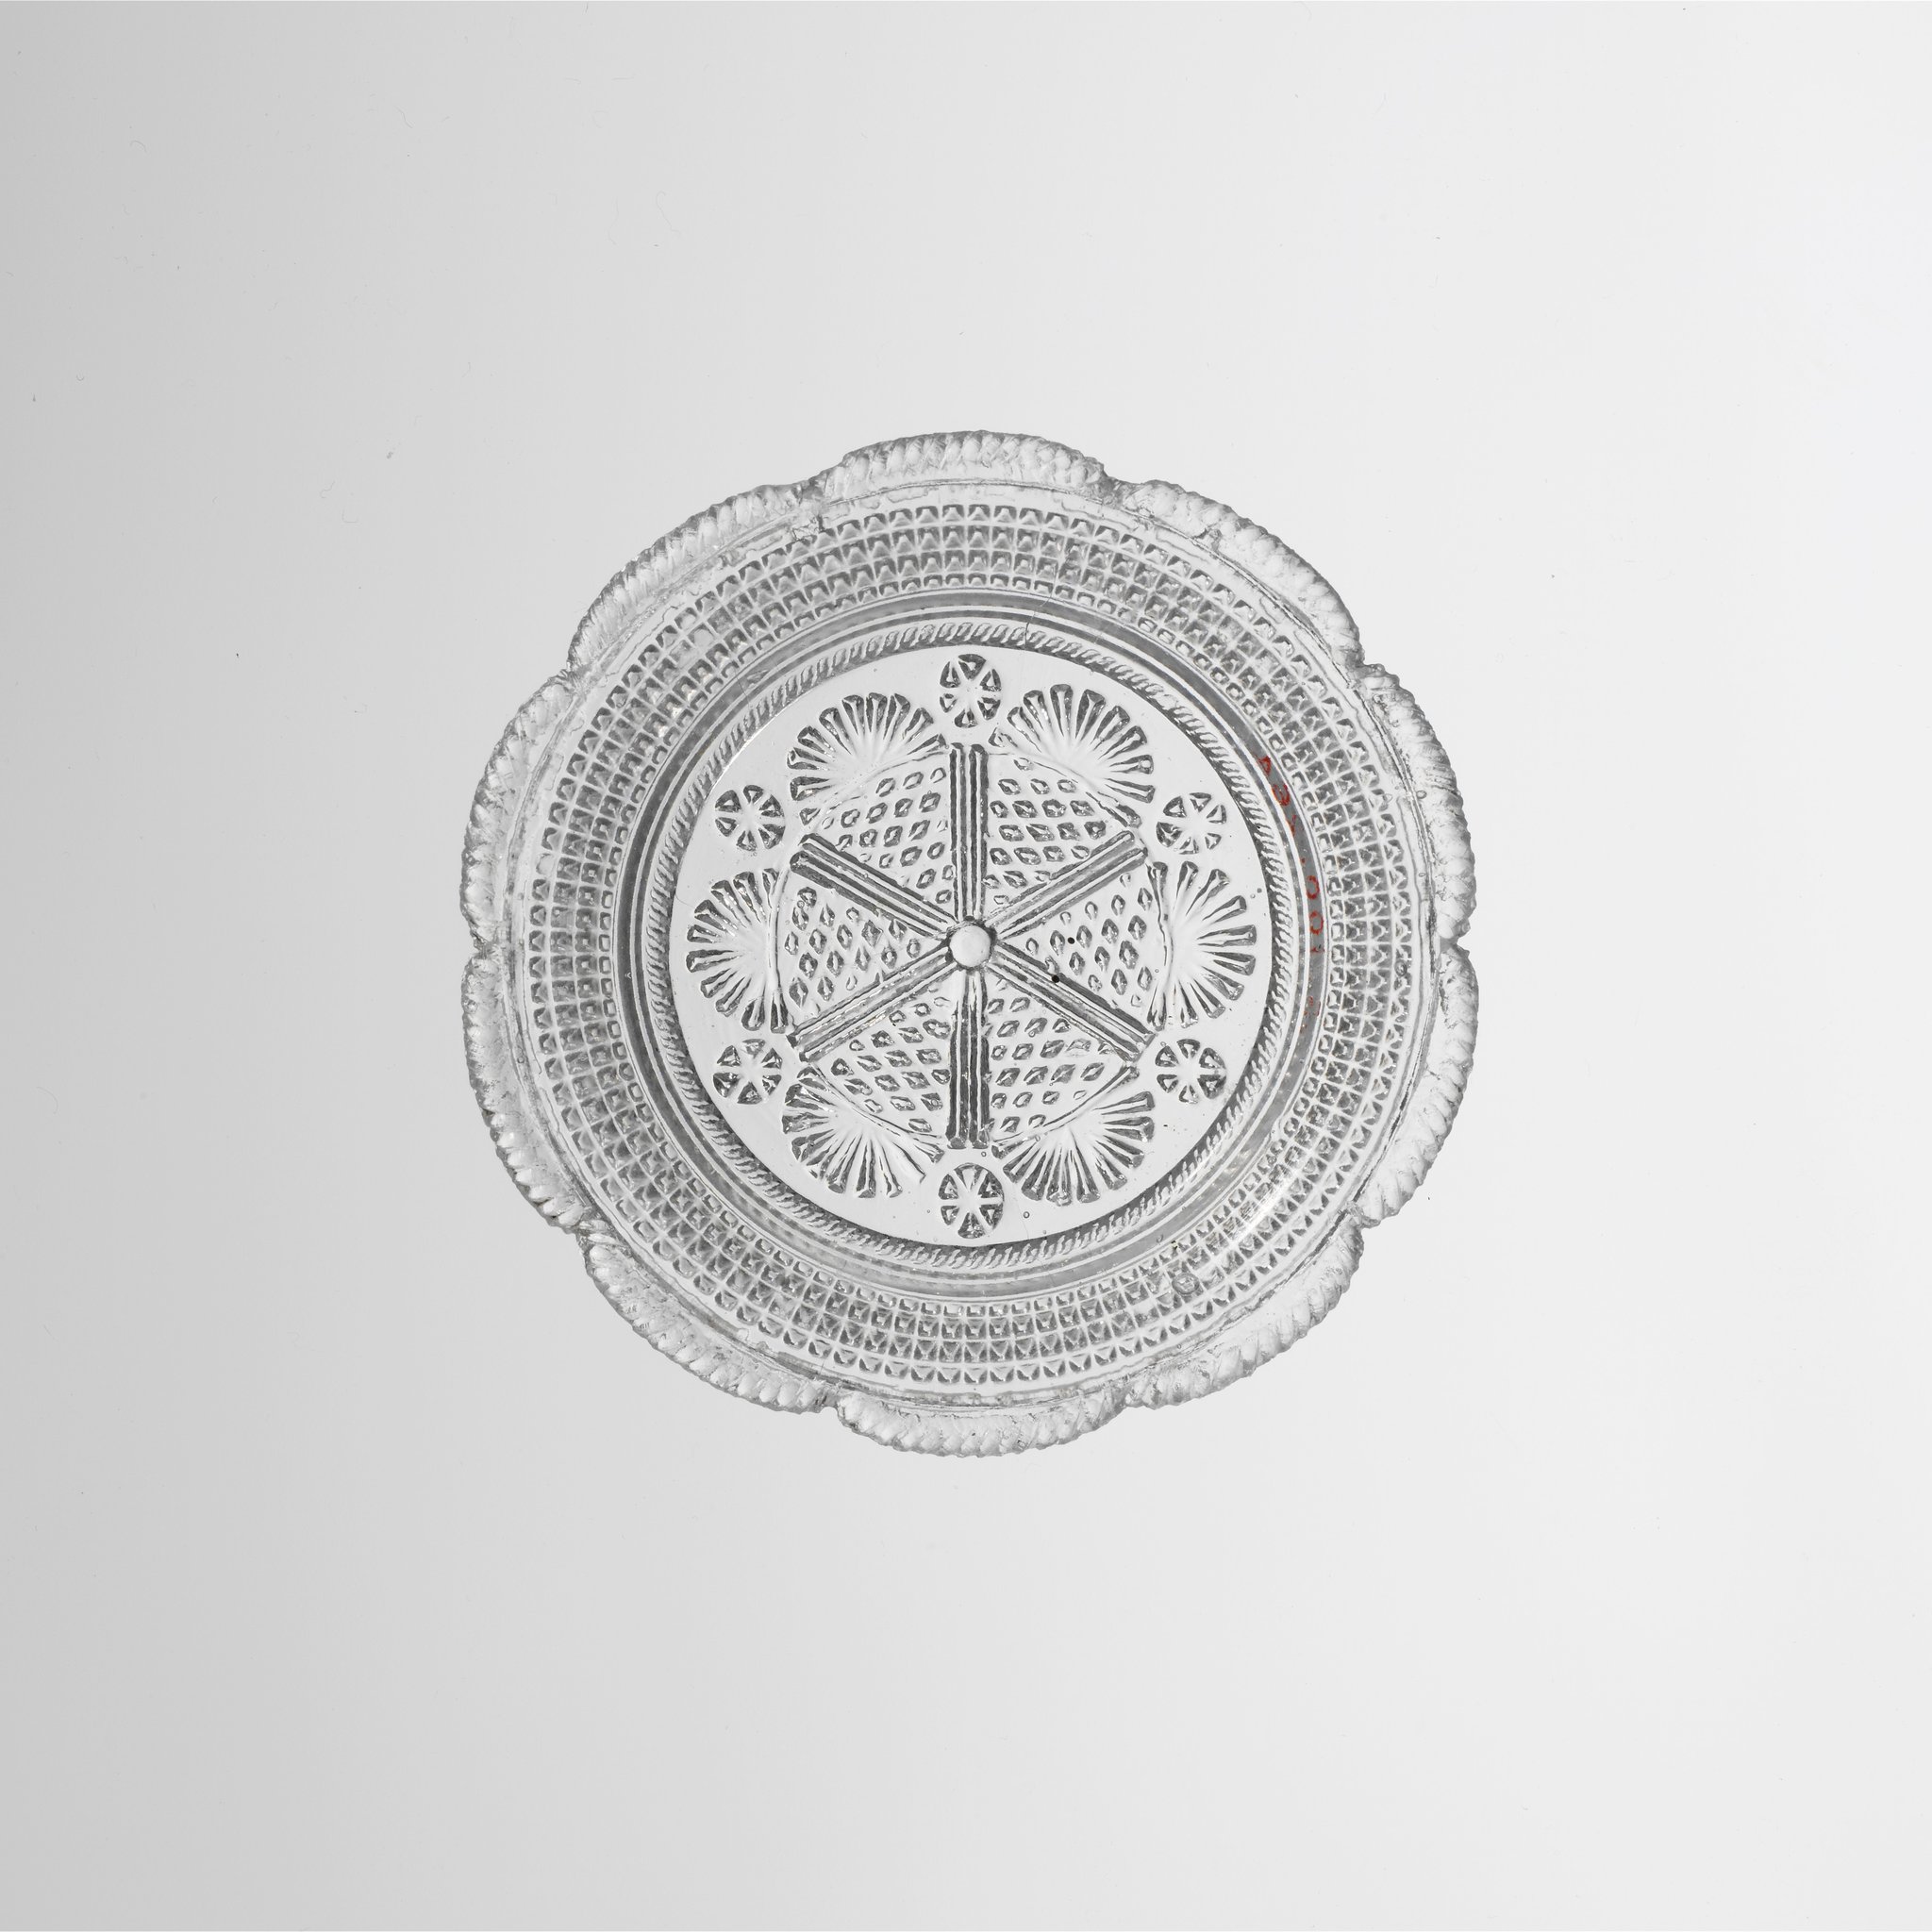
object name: cup plate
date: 1825-1860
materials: glass